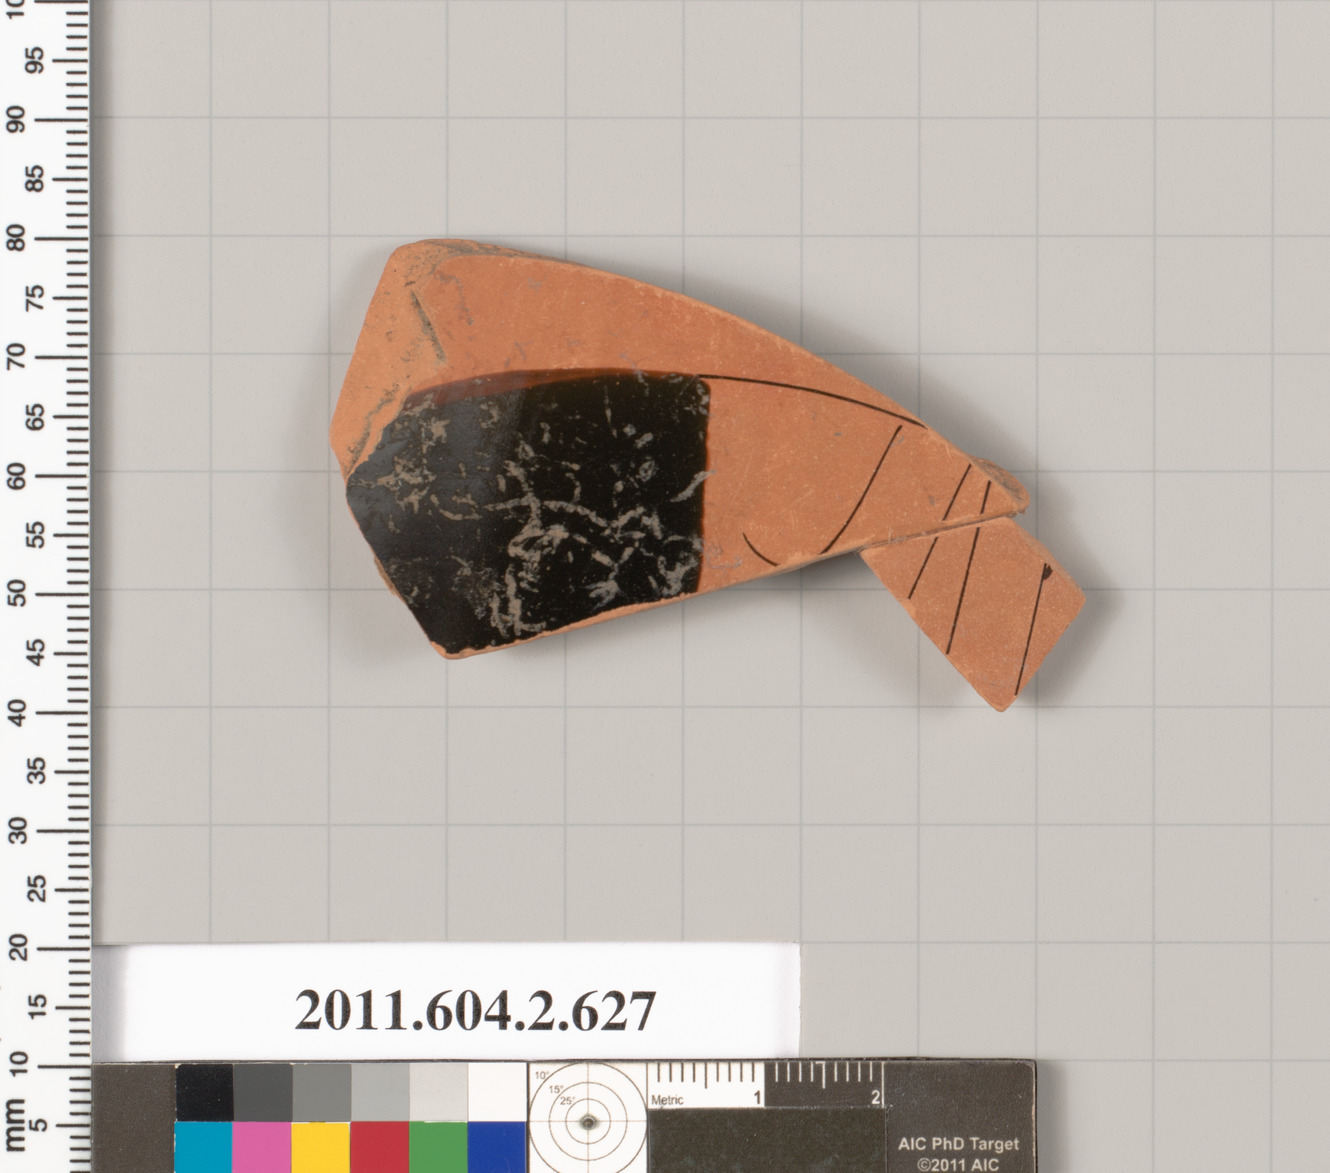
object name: column krater fragment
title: Terracotta fragment of a column-krater (bowl for mixing wine and water)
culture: greek, attic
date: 460-440 BCE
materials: terracotta